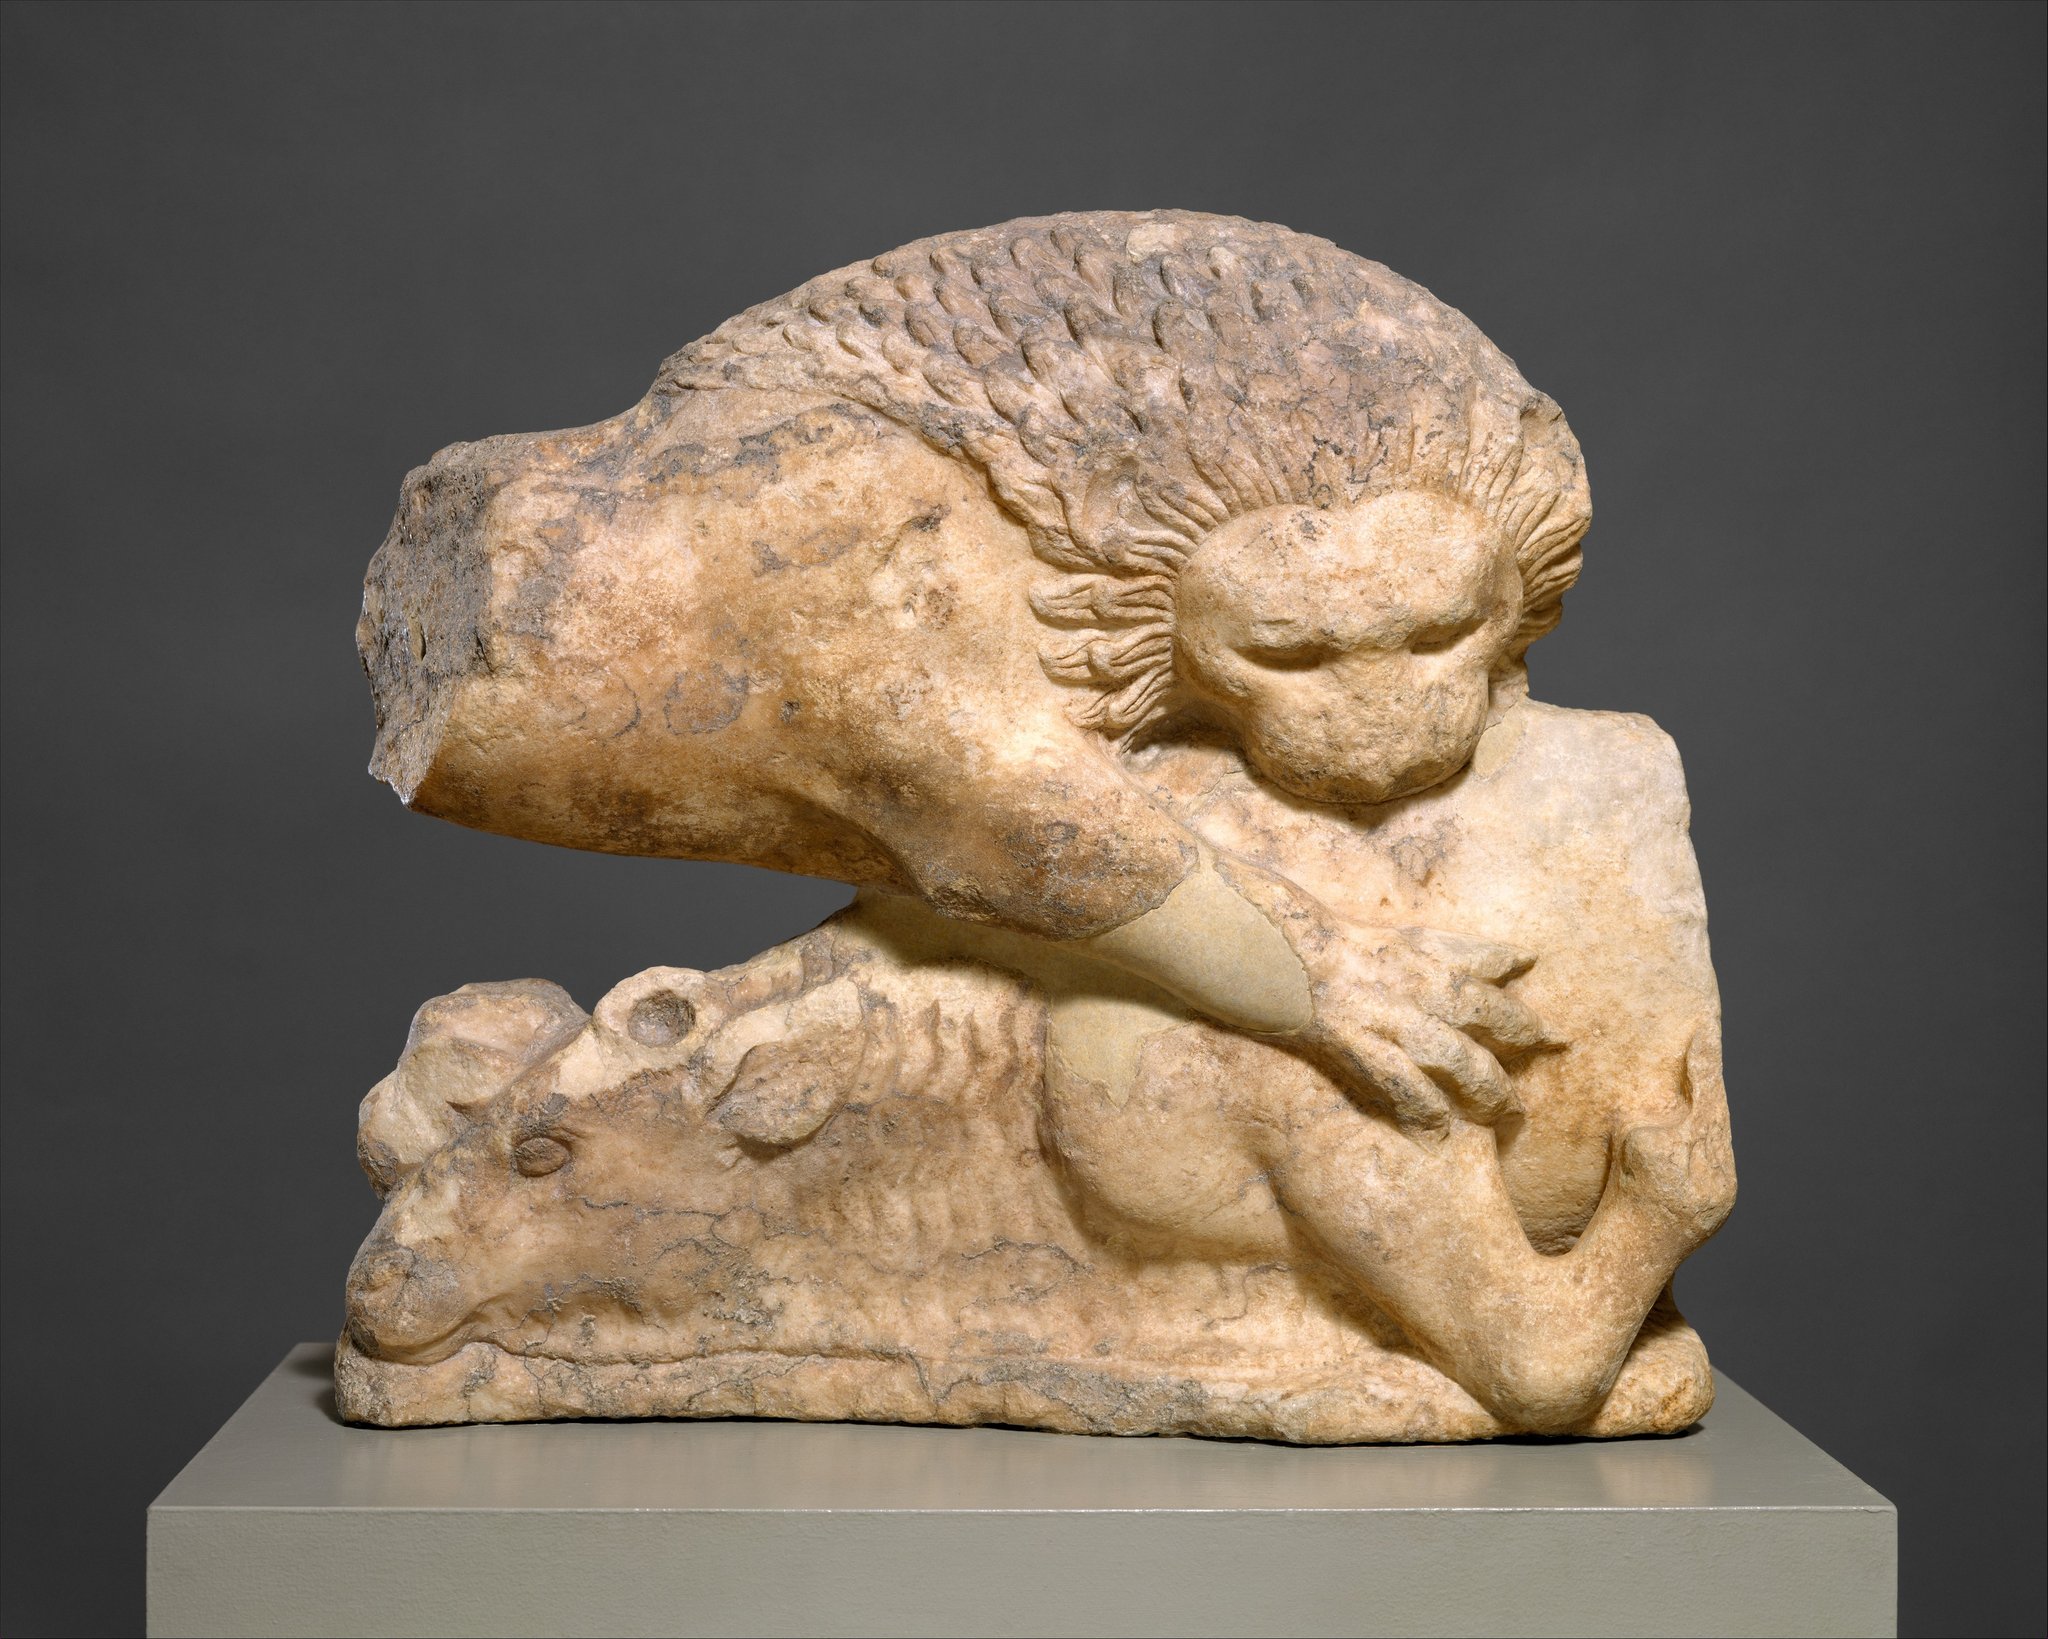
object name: relief of a lion attacking a bull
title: Lion felling a bull, from a marble pediment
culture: greek, attic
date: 525-500 BCE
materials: marble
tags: bulls,lions